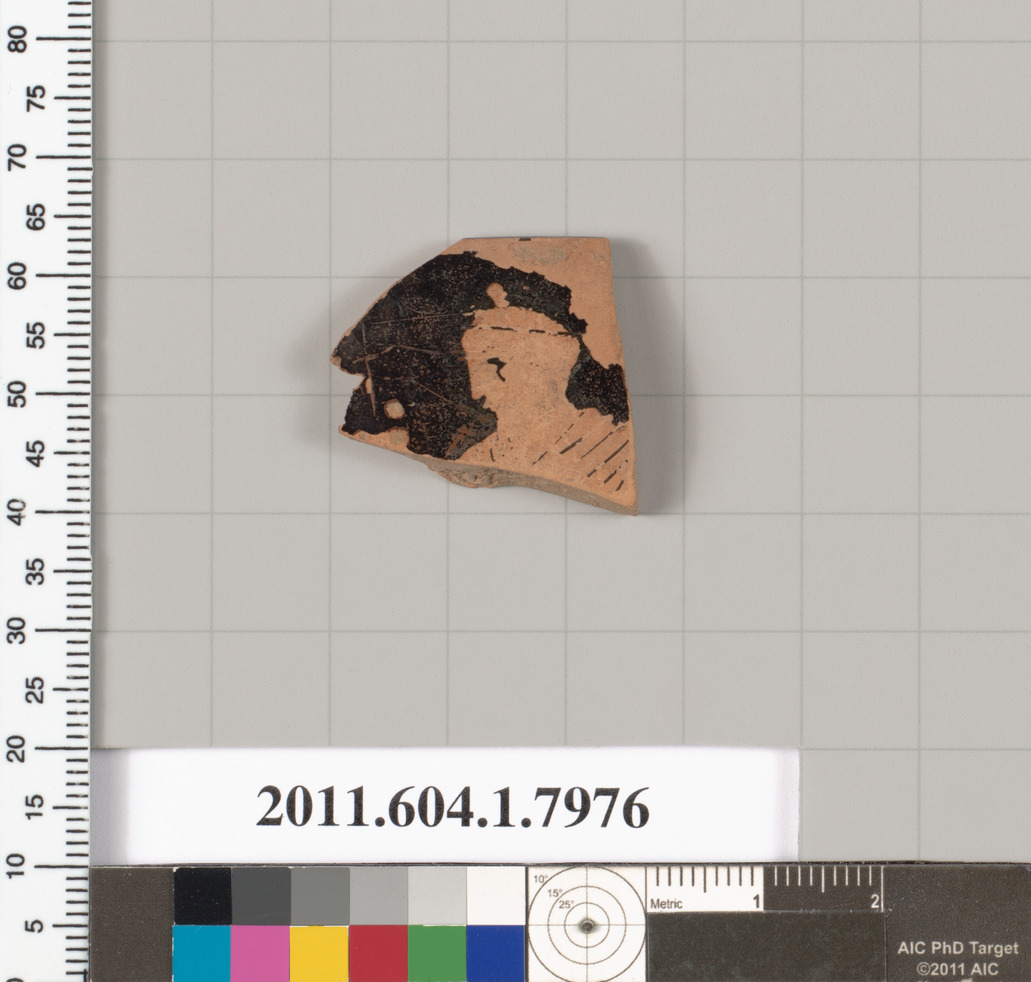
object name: kylix fragment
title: Terracotta rim fragment of a kylix (drinking cup)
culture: greek, attic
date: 460-450 BCE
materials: terracotta